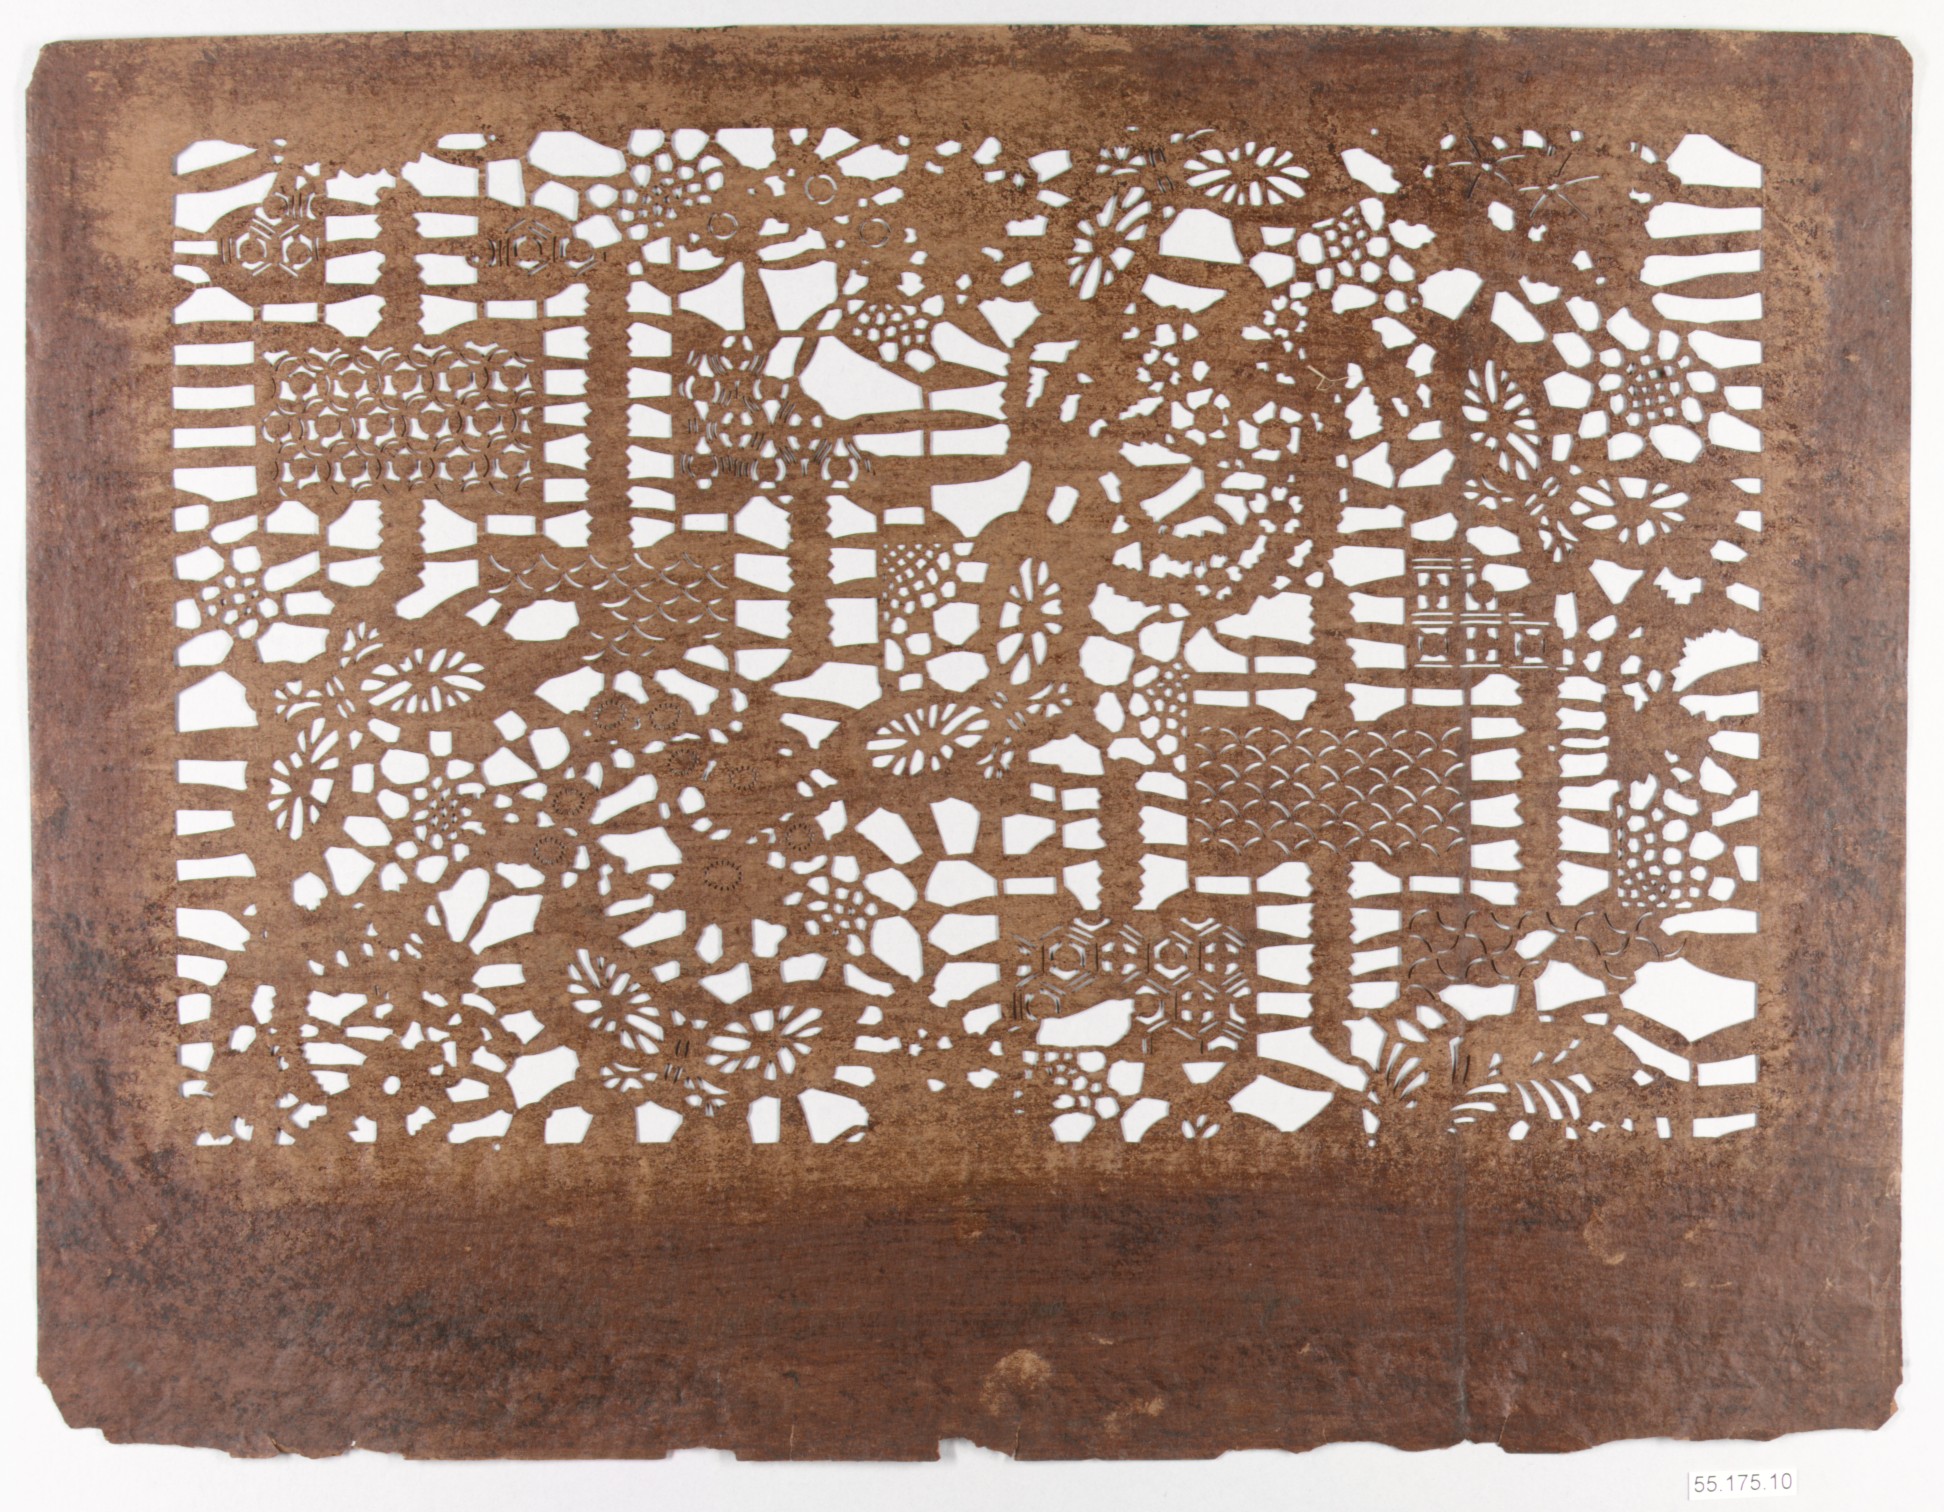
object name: stencil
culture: japanese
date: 1801-1900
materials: paper